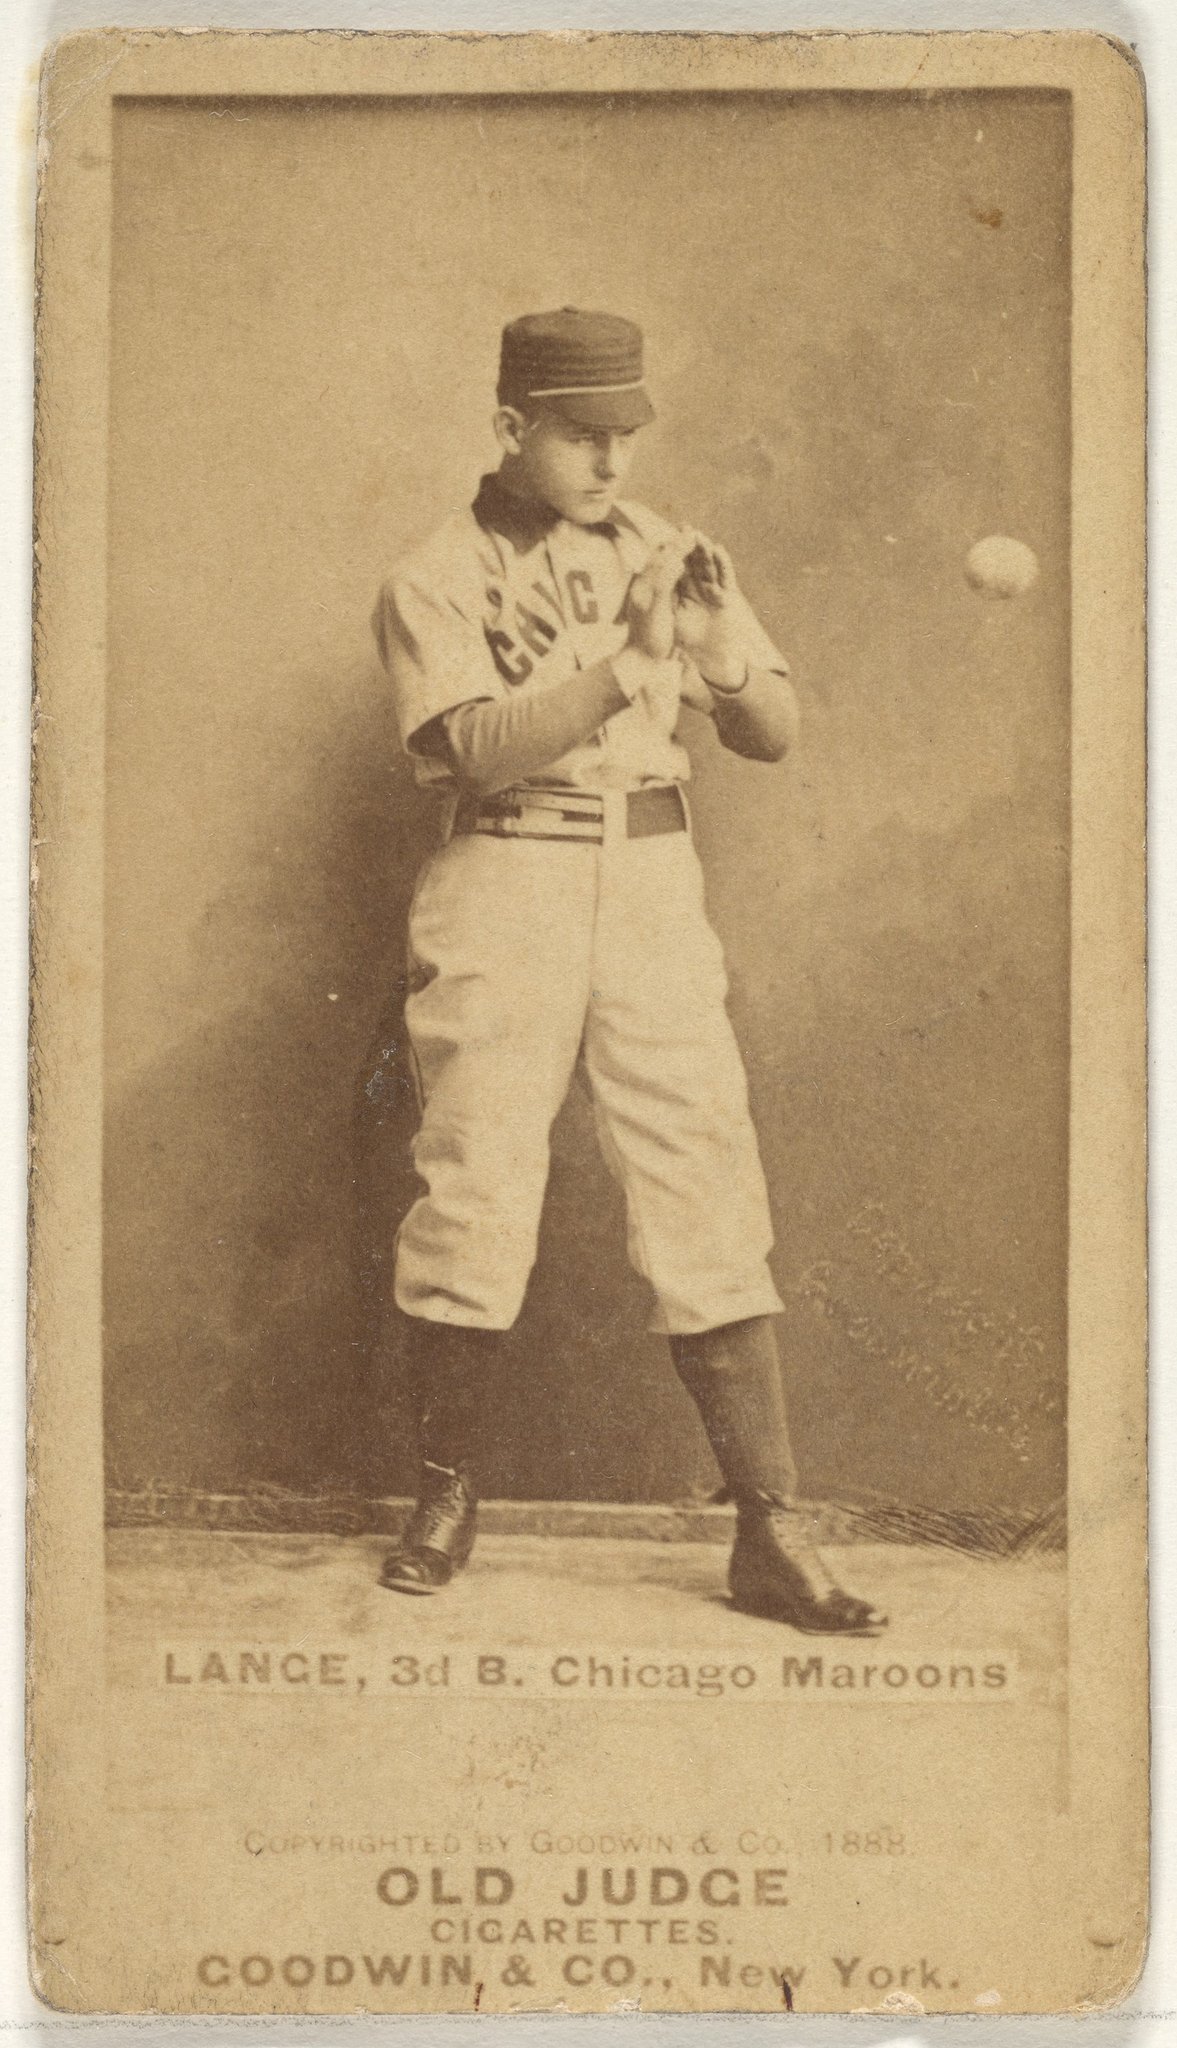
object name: baseball card, photograph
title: Lance, 3rd Base, Chicago, from the Old Judge series (N172) for Old Judge Cigarettes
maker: goodwin & company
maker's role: publisher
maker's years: 1850-1950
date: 1888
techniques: albumen silver print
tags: men,portraits,baseball,athletes